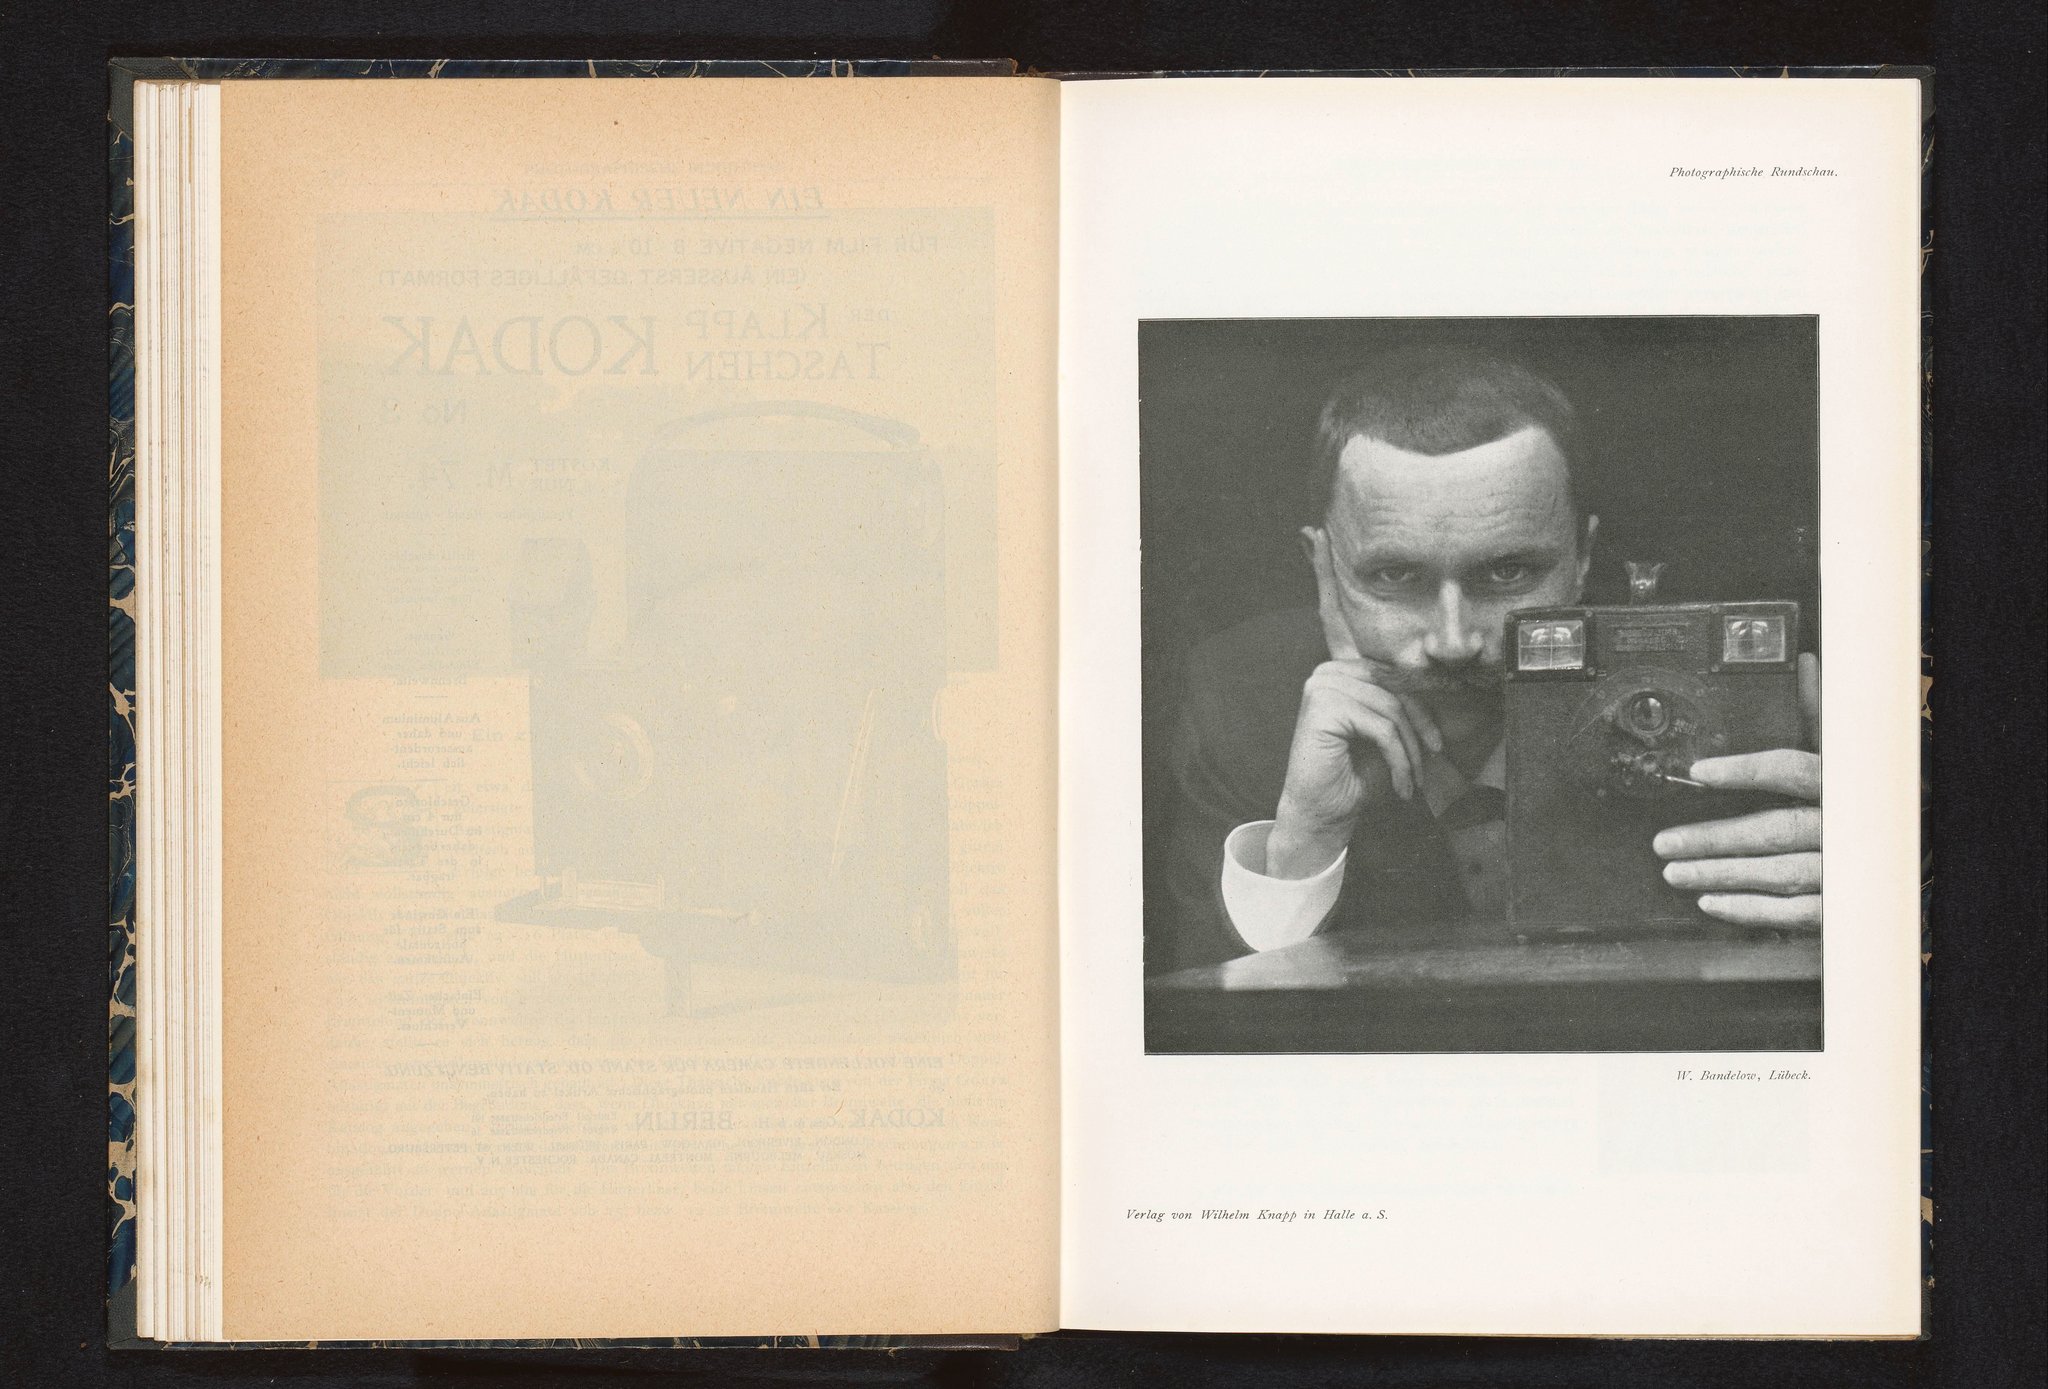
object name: page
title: Zelfportret van Wilhelm Bandelow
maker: Anonymous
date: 1896-1901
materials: paper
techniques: autotype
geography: halle an der saale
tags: wilhelm c. f. bandelow, historical persons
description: Prent op tweede ongenummerde pagina na pagina 32.